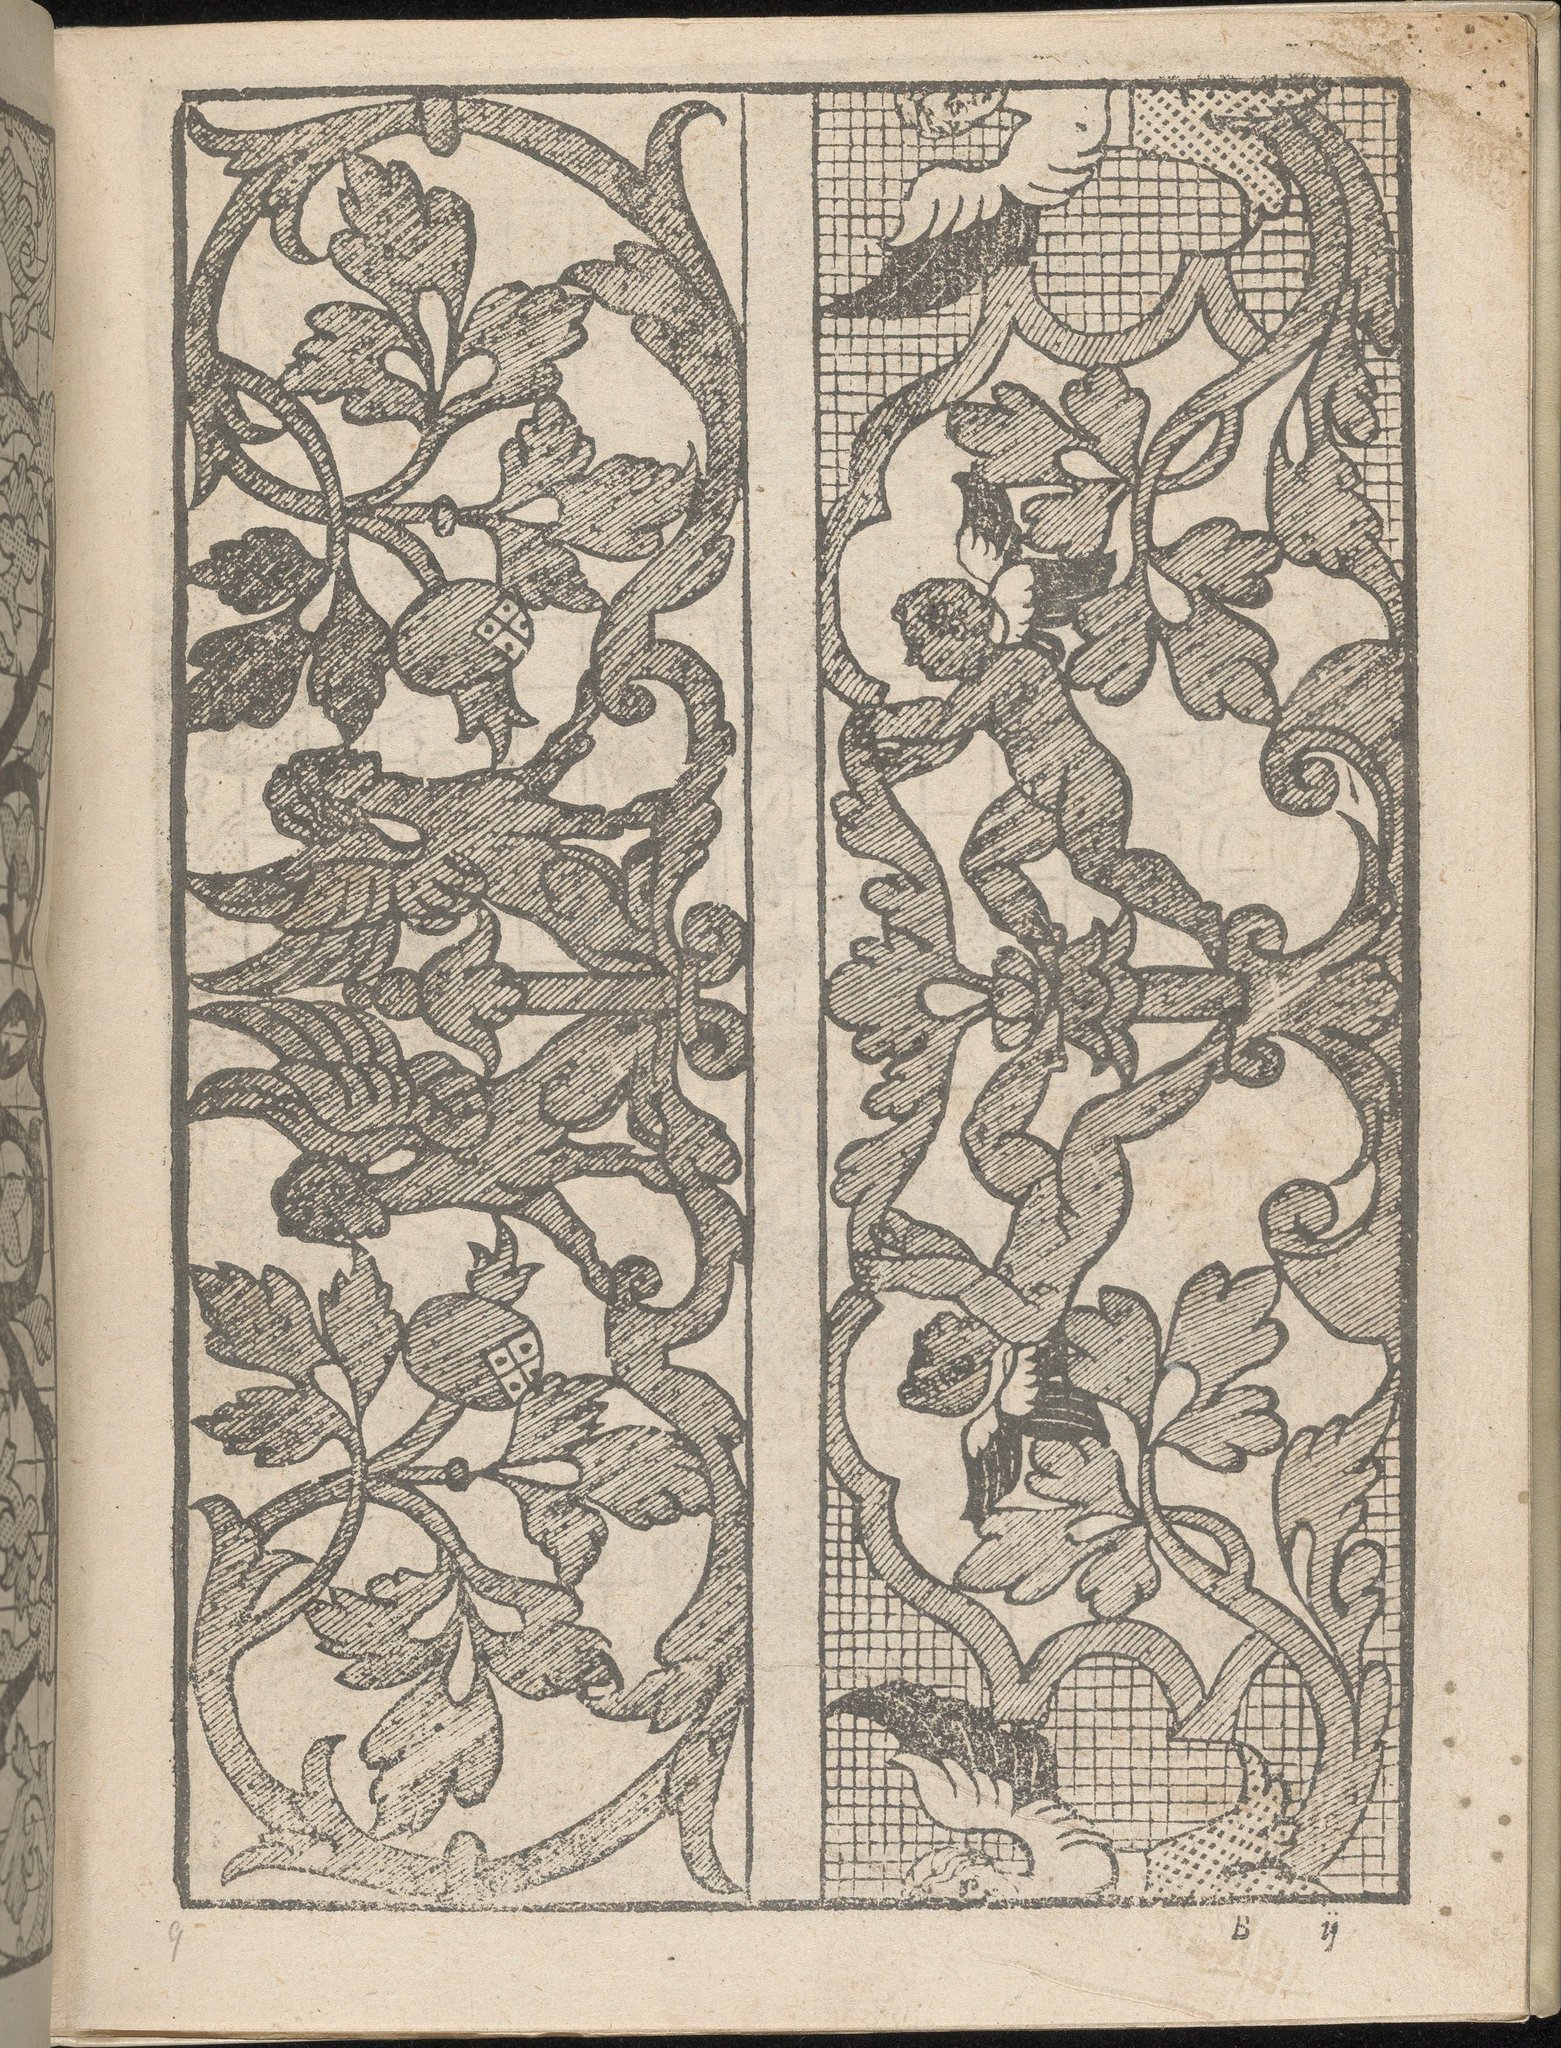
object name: book print ornament architecture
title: Lucidario di Recami, page 9 (verso)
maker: iseppo foresto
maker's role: designer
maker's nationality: italian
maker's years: 1520-1580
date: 1564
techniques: woodcut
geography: italy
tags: flowers